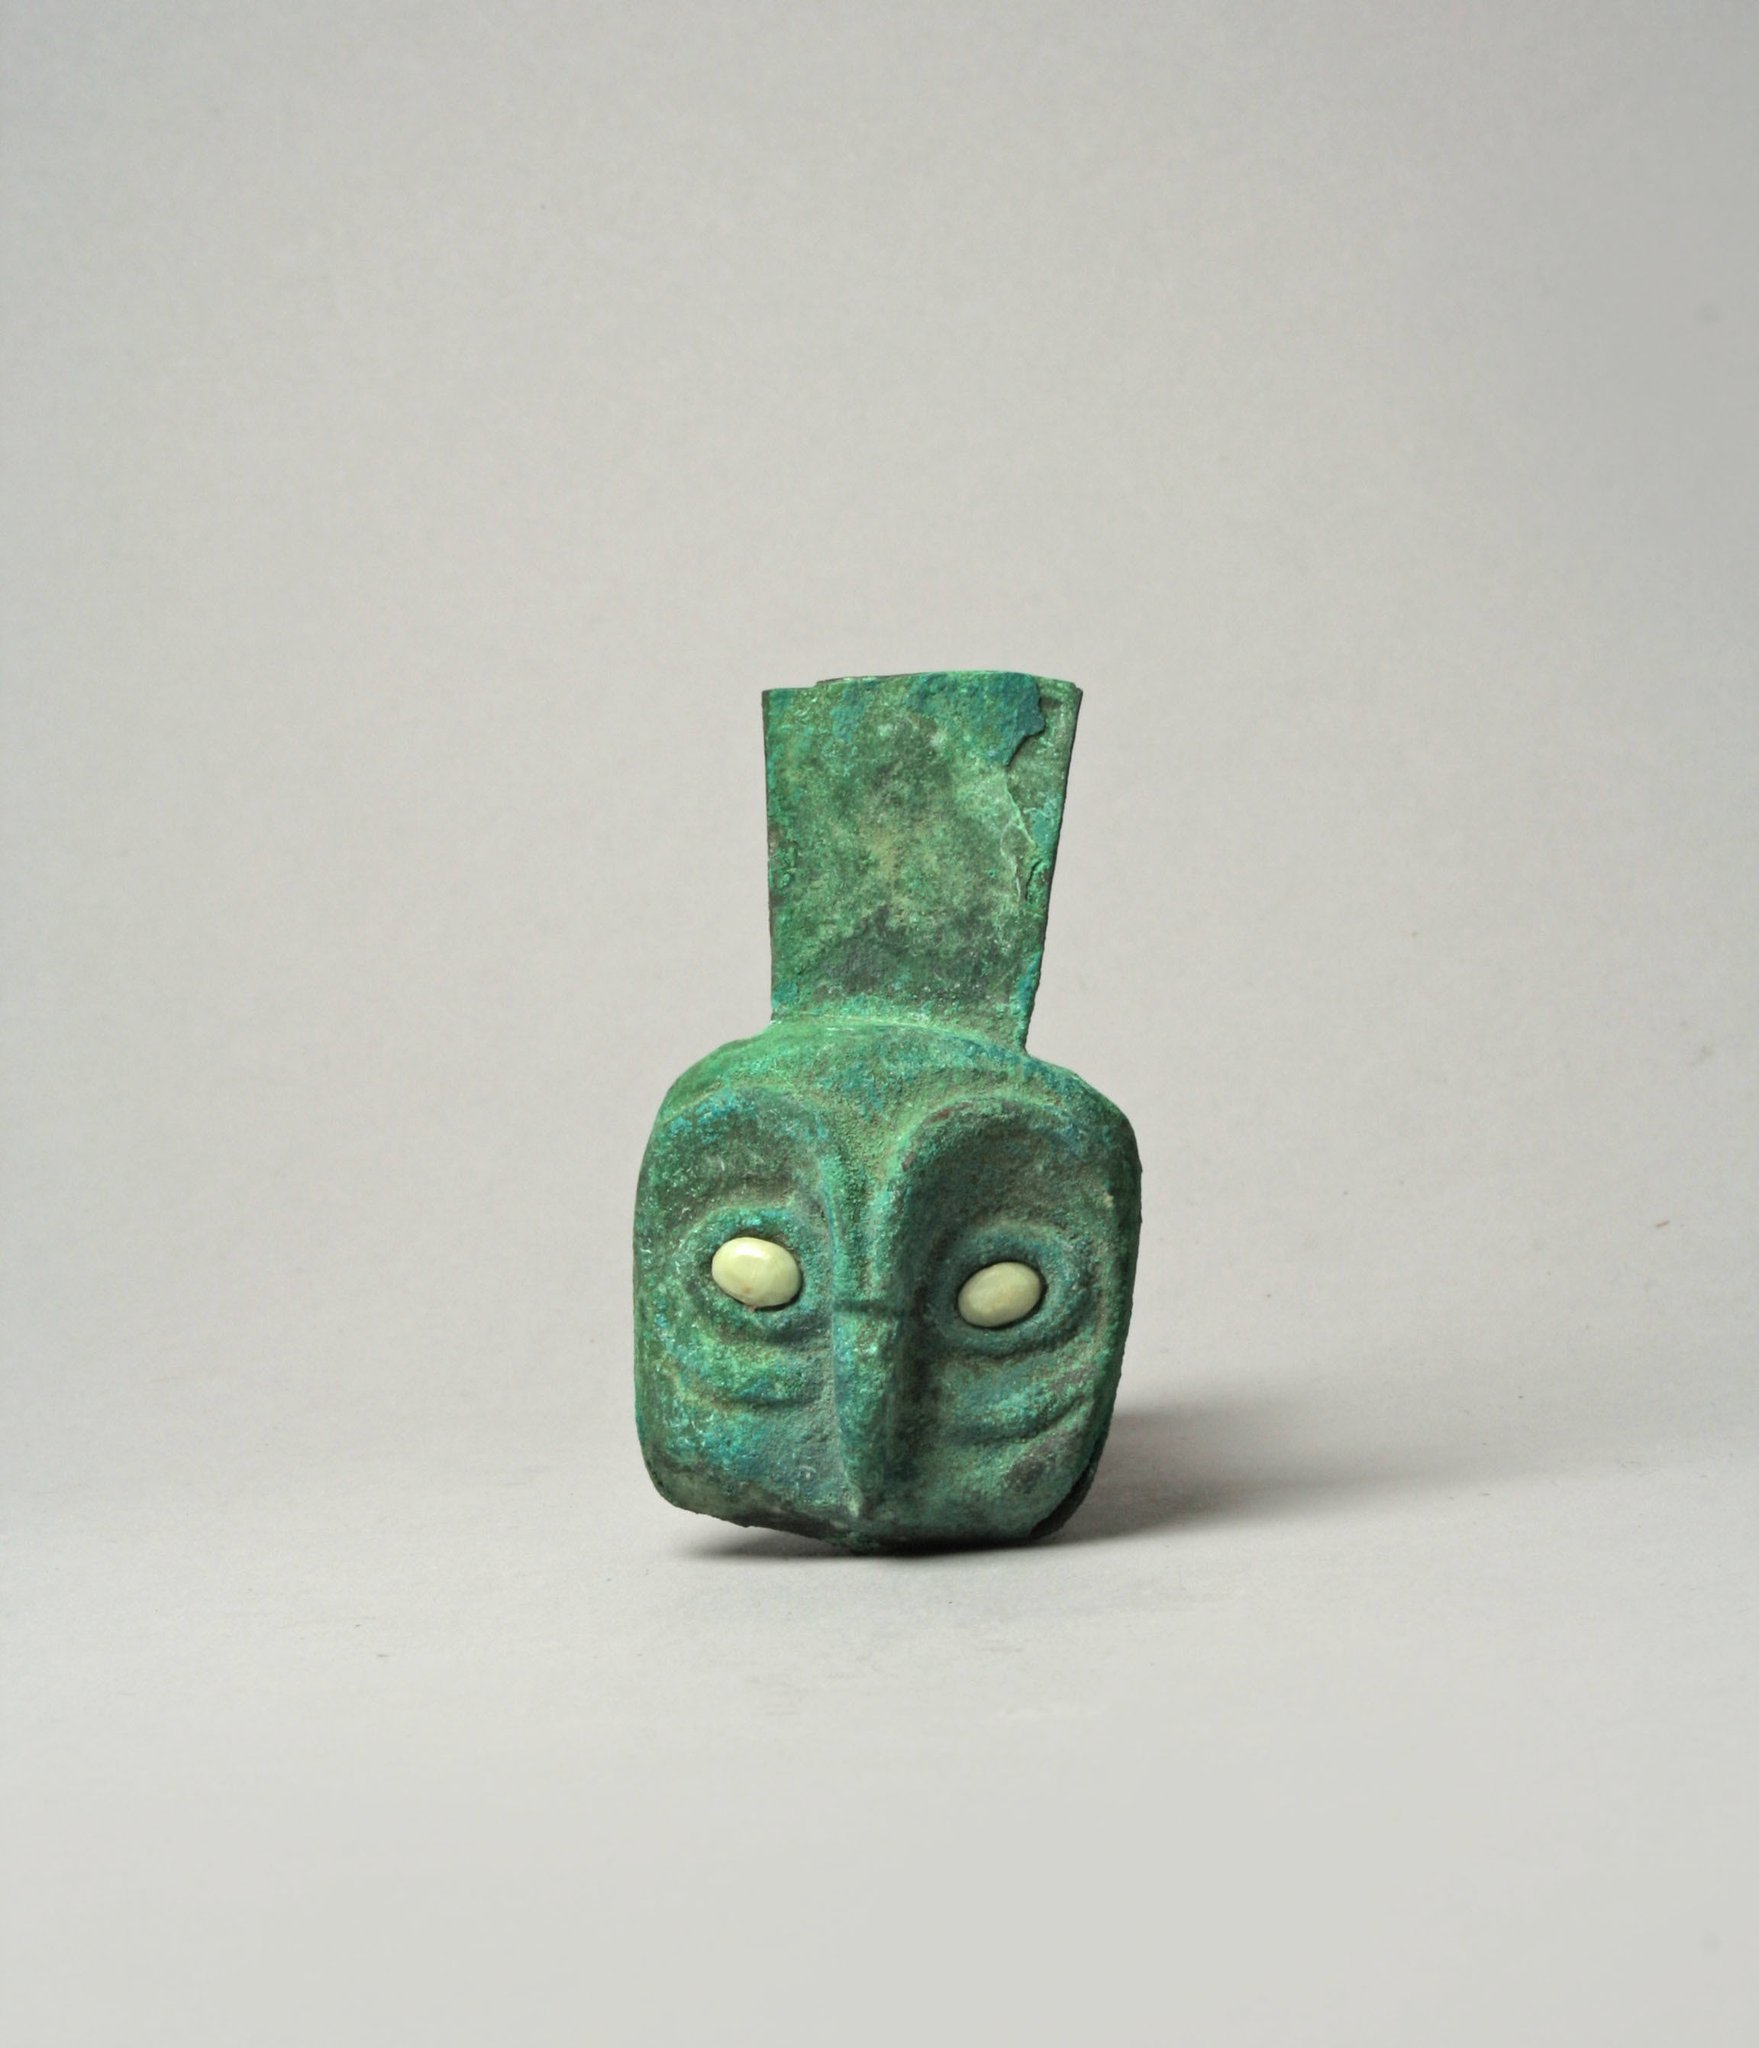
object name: ornament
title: Owl Tab Ornament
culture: moche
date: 501-700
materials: metal, stone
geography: peru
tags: owls